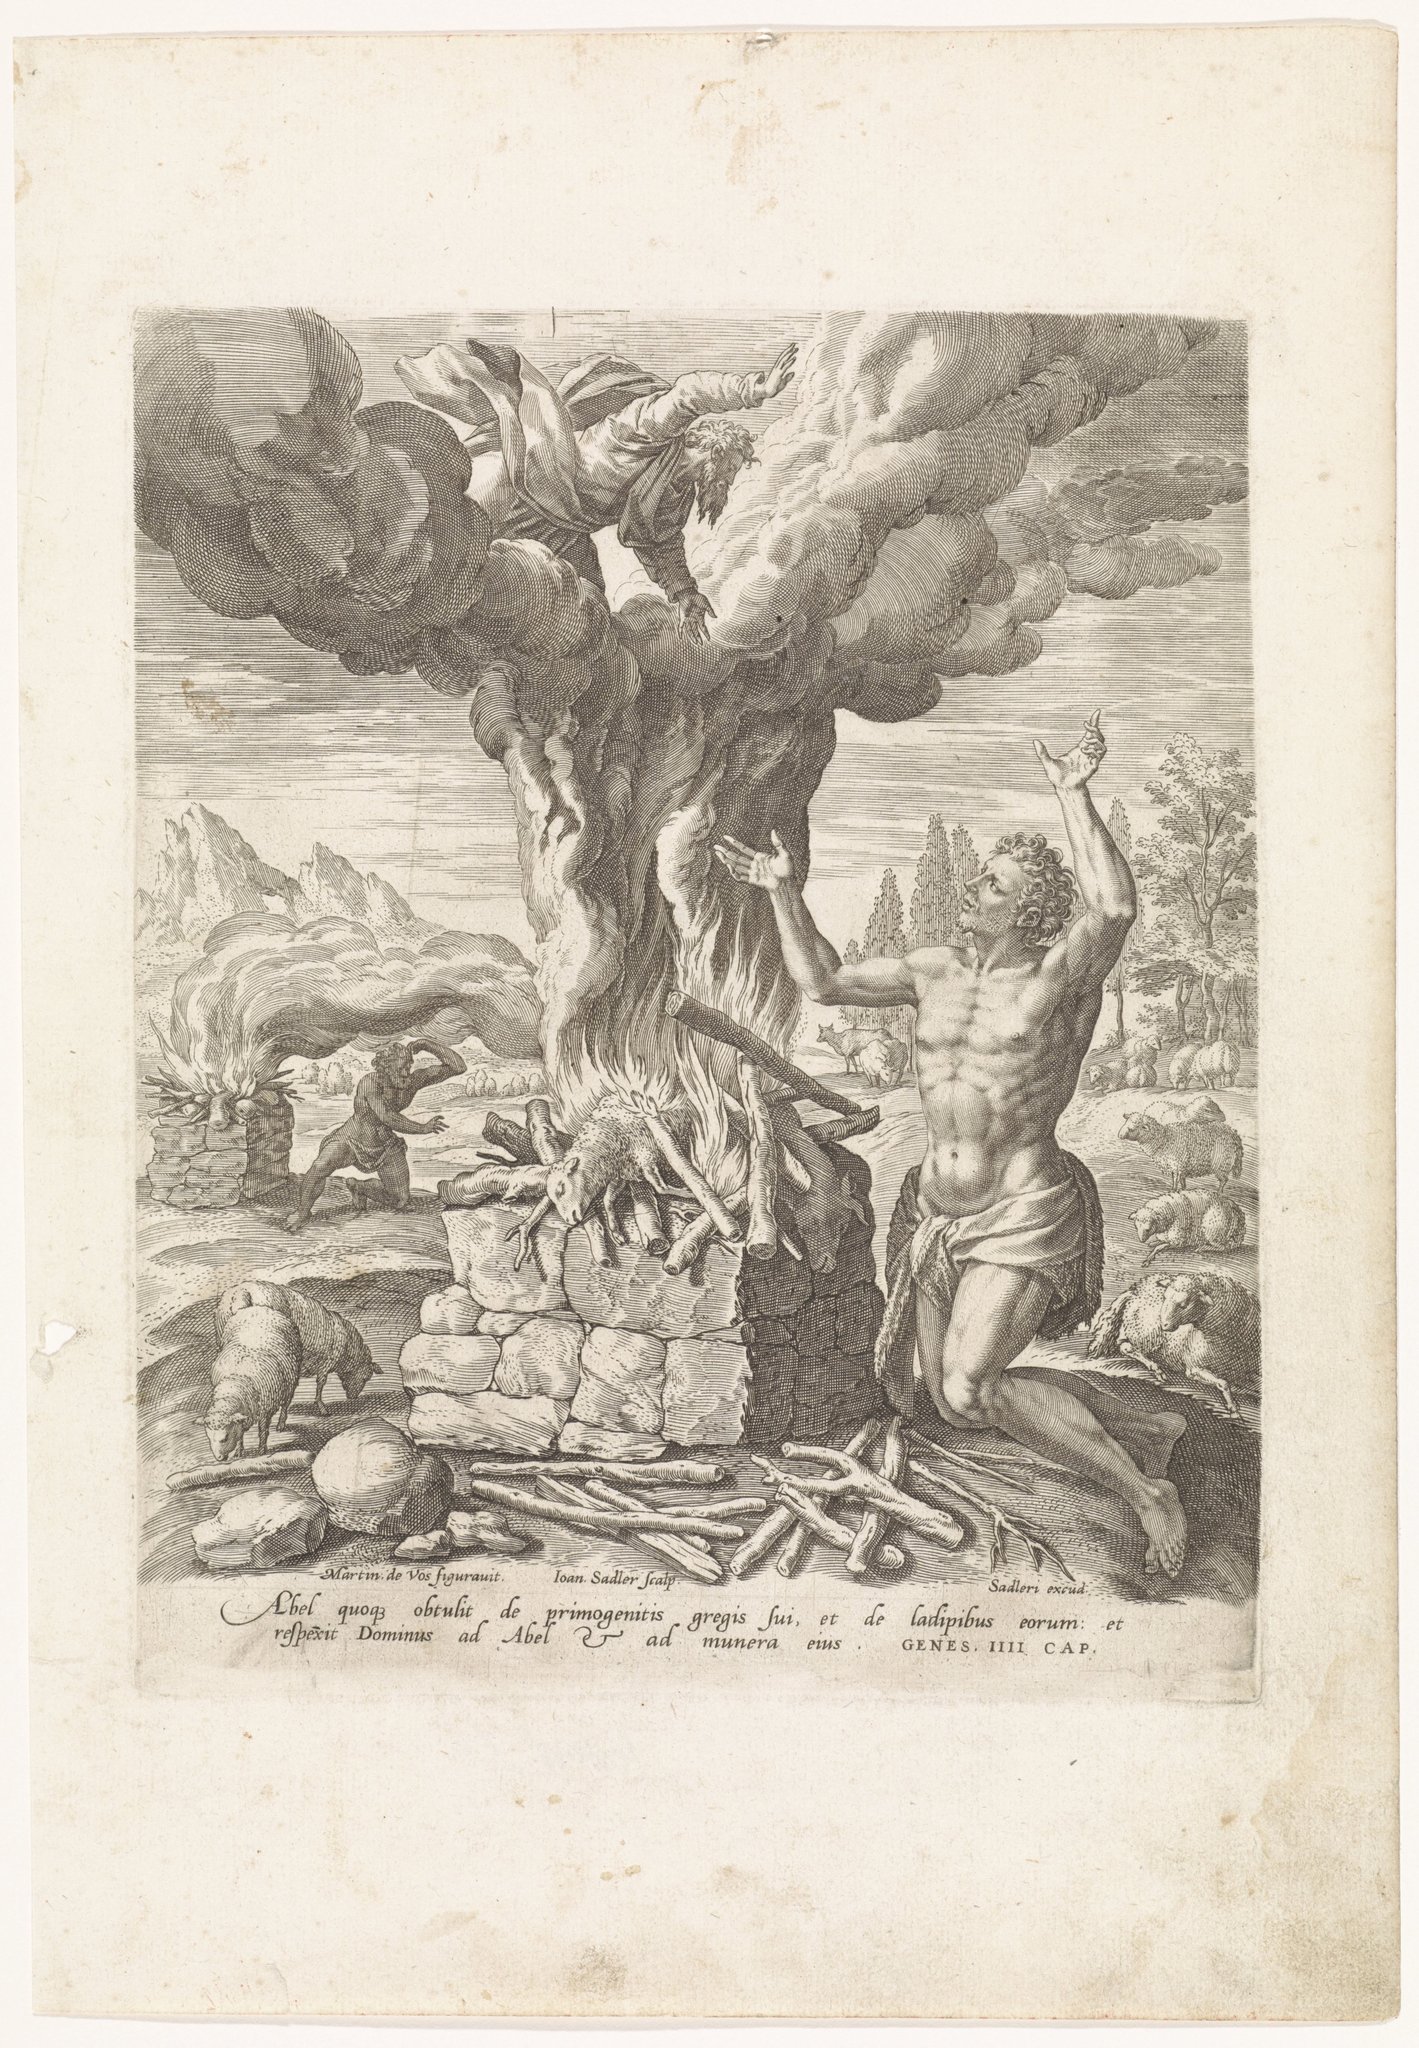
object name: print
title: Offer van Abel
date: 1580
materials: paper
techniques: engraving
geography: antwerp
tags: god the father as bearded old man, usually with crown or tiara or sceptre and/or globe, the fume of abel's sacrifice goes straight to heaven, whereas the smoke of cain's offering is beaten down, god (or the hand of god) appears and blesses abel ~ sacrifice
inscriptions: collector's mark: Lugt 2228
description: Het offer van Abel. Op de voorgrond Abels offeraltaar, waarop schapen worden geofferd. De rook gaat omhoog. Op de achtergrond Kaïns offeraltaar, waarop groenten worden geofferd. De rook van het offer stijgt niet omhoog. Boven in de lucht verschijnt God in de wolken. God keurt Abels offer goed. De prent heeft een Latijns onderschrift en is de eerste prent uit een negendelige serie met scènes uit het Oude Testament.